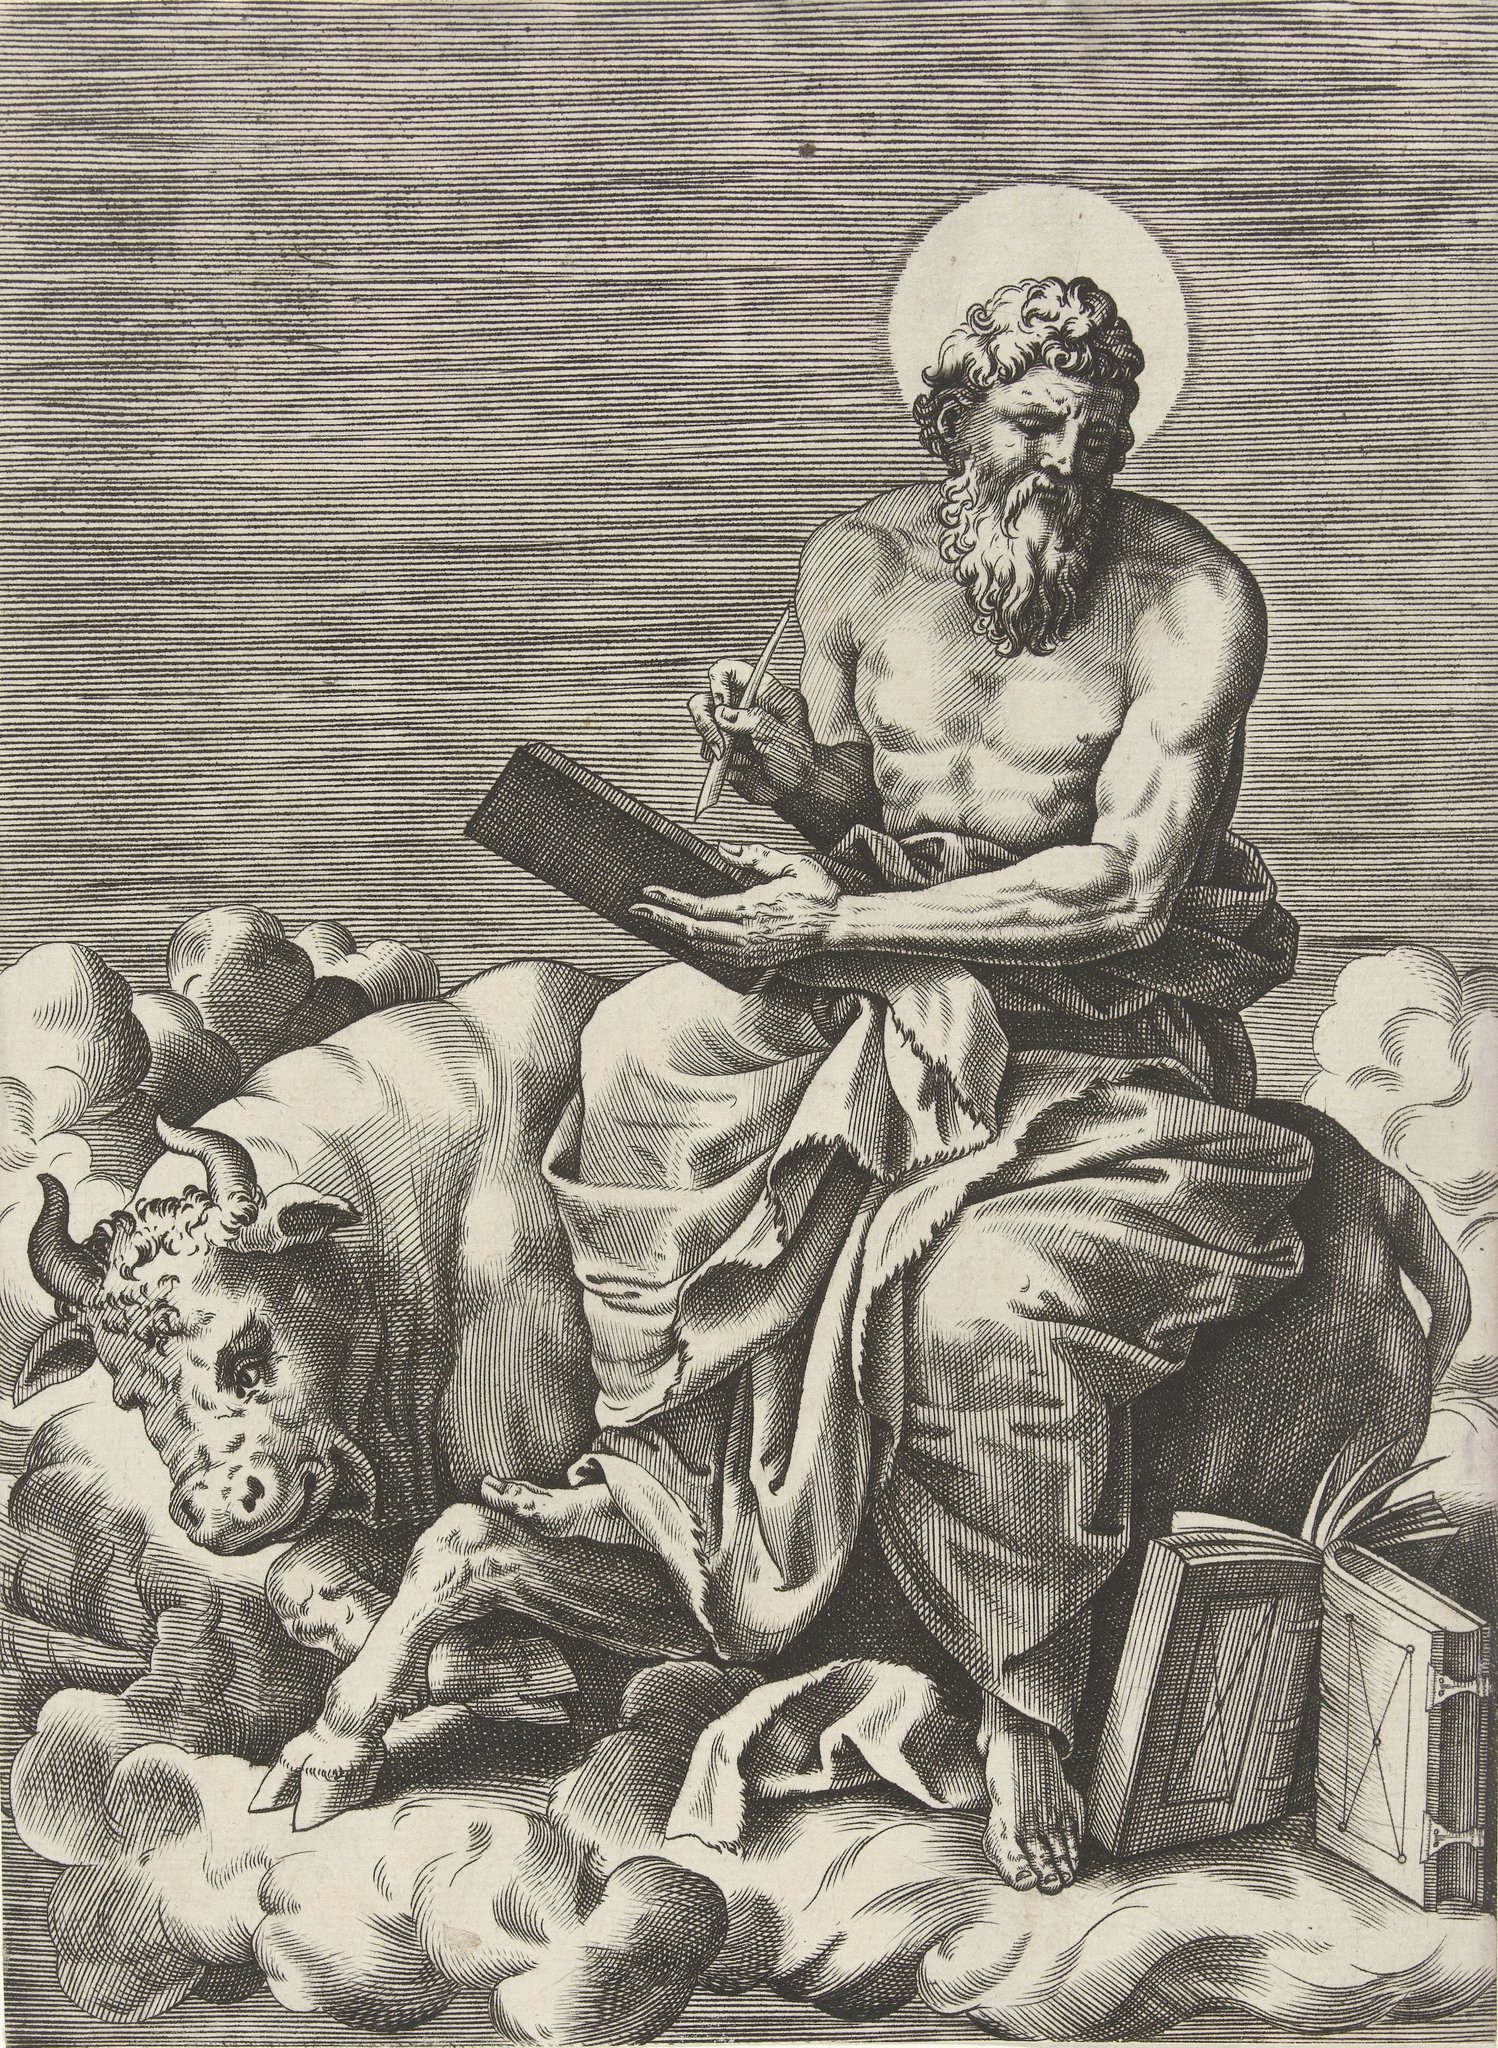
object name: print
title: De vier evangelisten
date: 1554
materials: paper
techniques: engraving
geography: antwerp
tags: luke the evangelist; possible attributes: book, (winged) ox, portrait of the virgin, surgical instruments, painter's utensils, scroll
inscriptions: collector's mark: Lugt 2228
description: De evangelist Lucas tussen de wolken zittend op zijn attribuut, een van de vier apocalyptische wezens, de os. Prent uit een serie van vier.